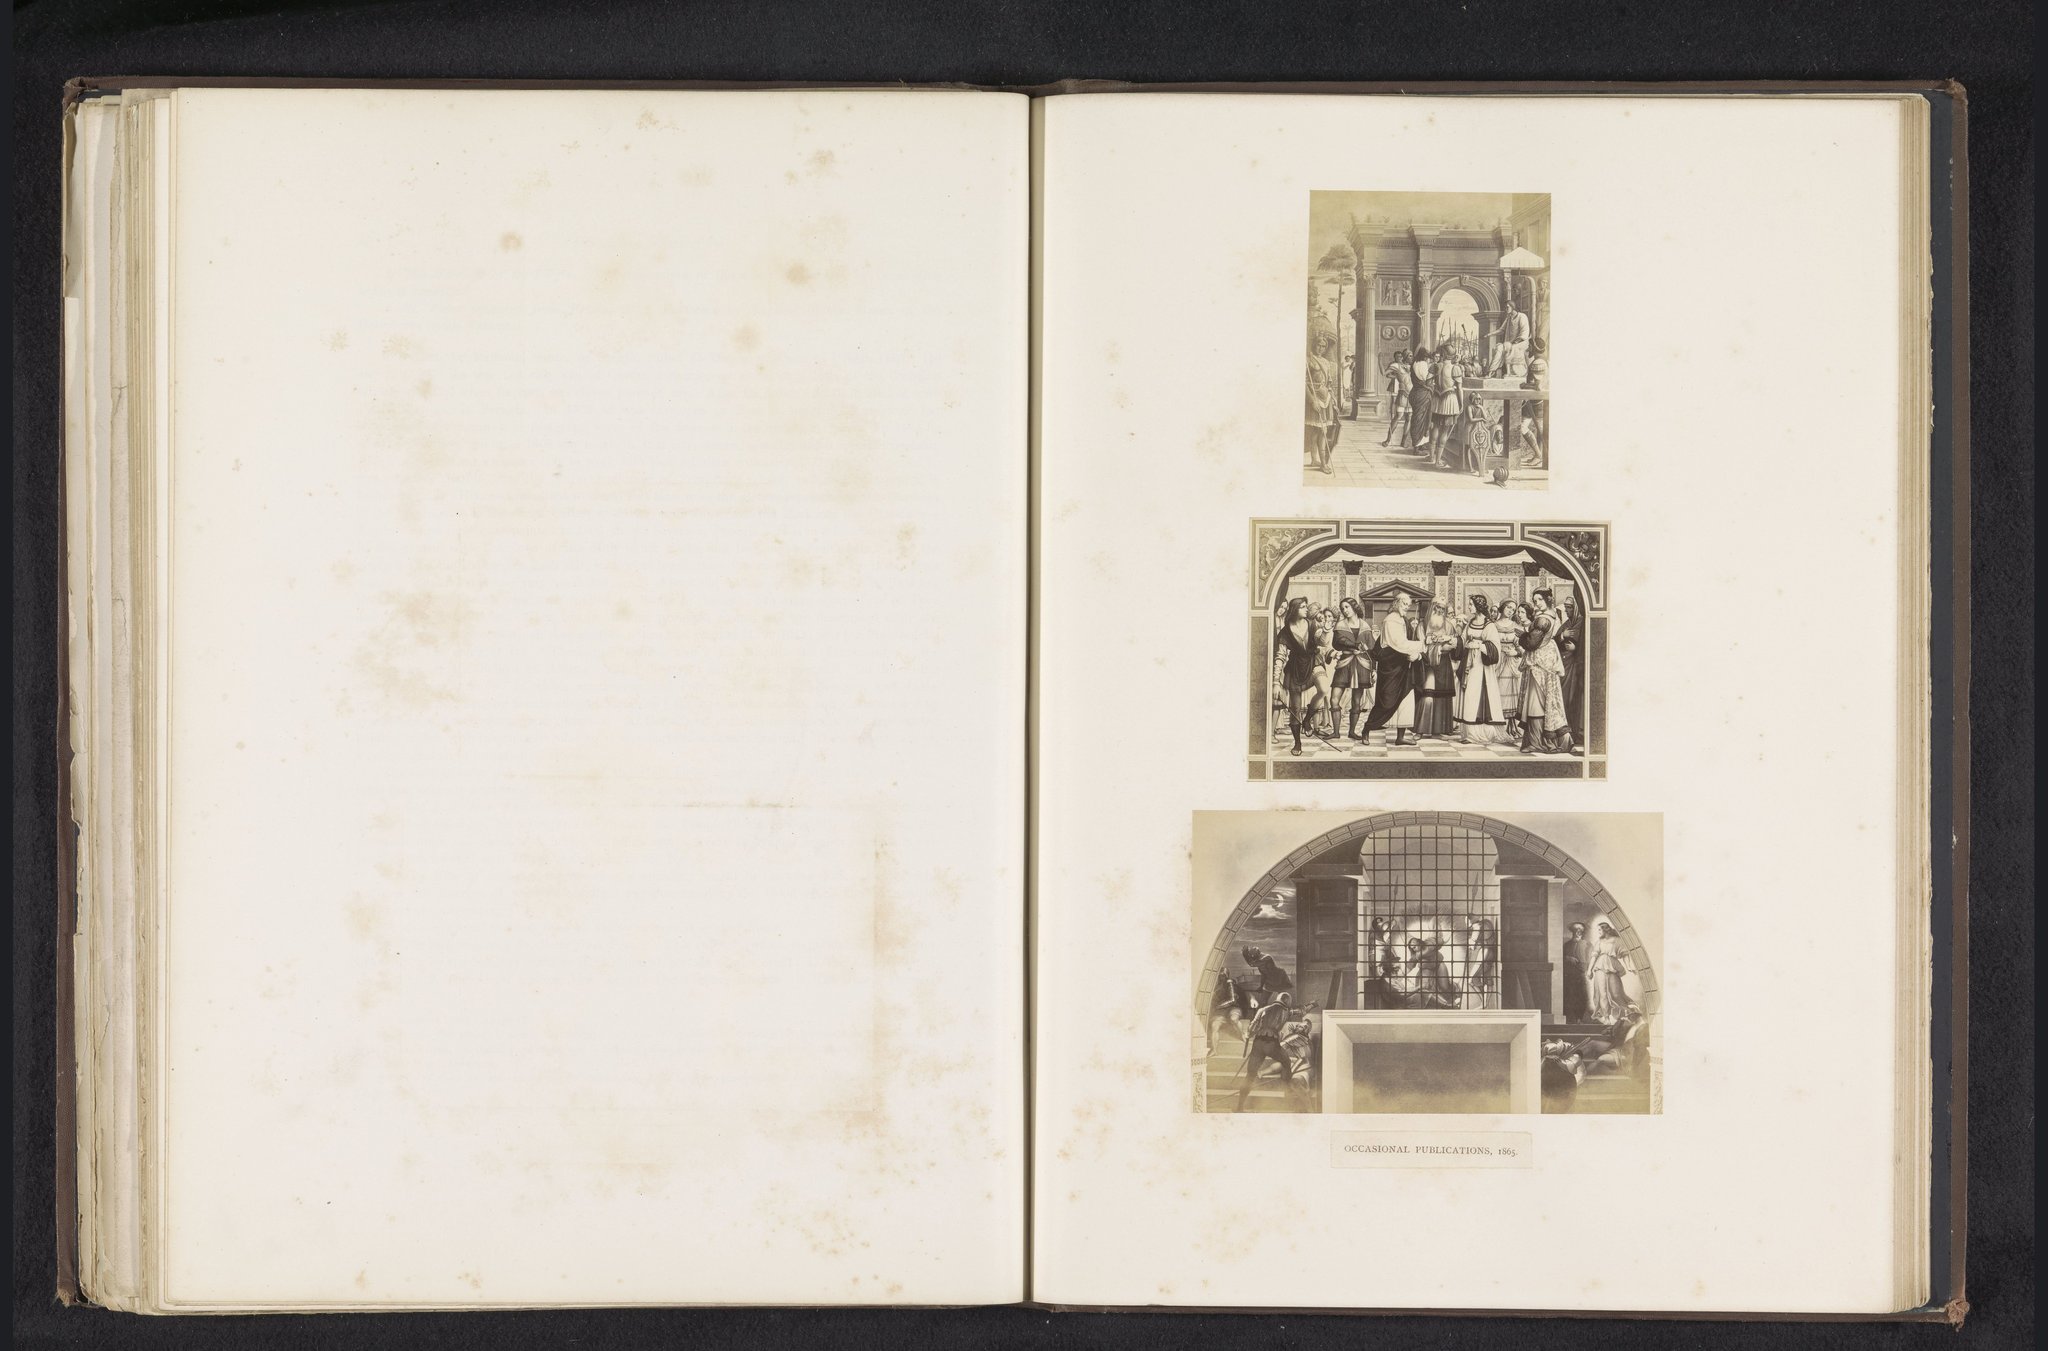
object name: page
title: Drie fotoreproducties van een publicatie door de Arundel Society met schilderijen en een fresco naar Rafaël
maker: Anonymous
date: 1859-1869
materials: photographic support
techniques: albumen print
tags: book, painting (including book-illumination, miniature-painting)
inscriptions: inscription: ‘occasional publications, 1865.’